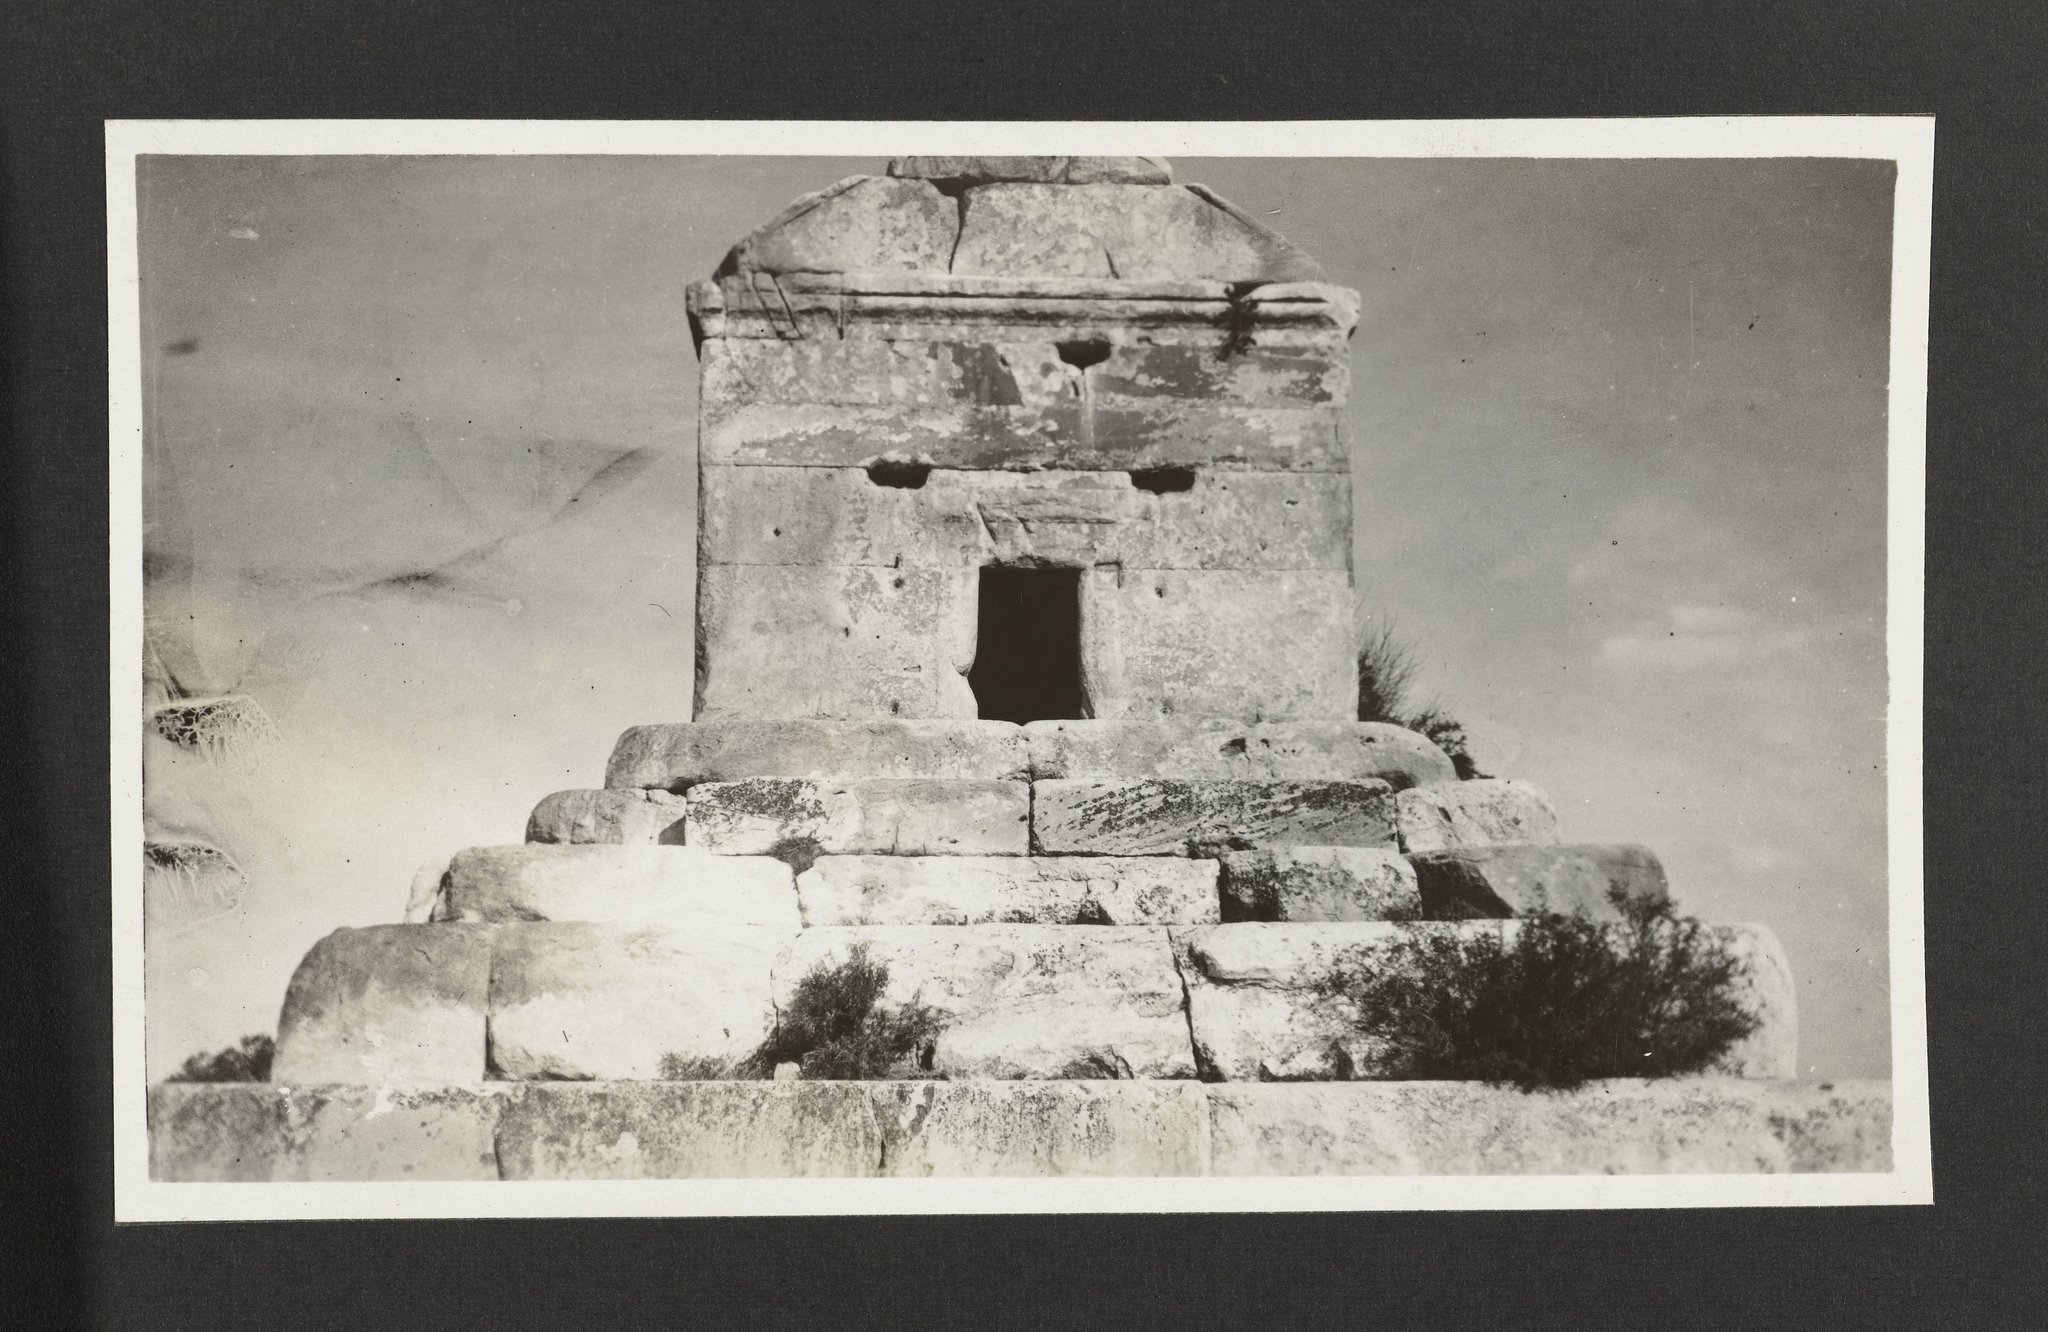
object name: photograph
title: Graf van Cyrus, een eenzaam uit de vlakte opryzend monument (naby het gehucht Masjid-i-Mader-i-Suleiman).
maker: a.g.a. van eelde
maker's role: engineer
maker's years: 1862-1950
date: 1925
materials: cardboard, paper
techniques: gelatin silver print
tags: iran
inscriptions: number: ‘19.’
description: Titel op object afkomstig uit inventaris (Verklaring der Photo's) behorend bij het album.